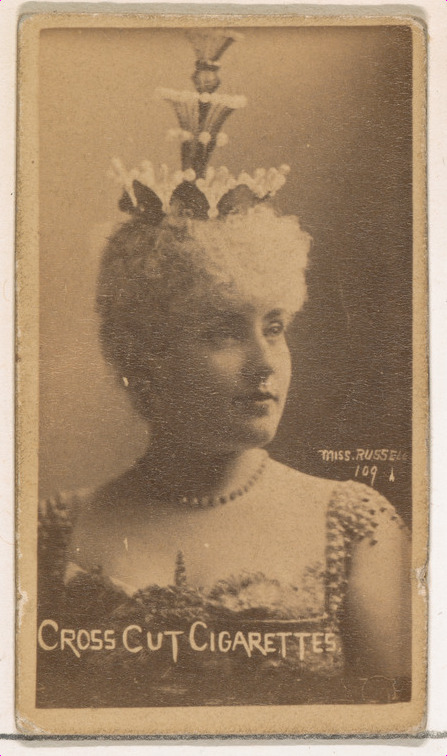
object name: print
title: Card Number 109, Lillian Russell, from the Actors and Actresses series (N145-1) issued by Duke Sons & Co. to promote Cross Cut Cigarettes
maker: w. duke, sons & co.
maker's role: publisher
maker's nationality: american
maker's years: 1870-1920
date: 1880-1889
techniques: albumen silver print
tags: portraits,women,actresses